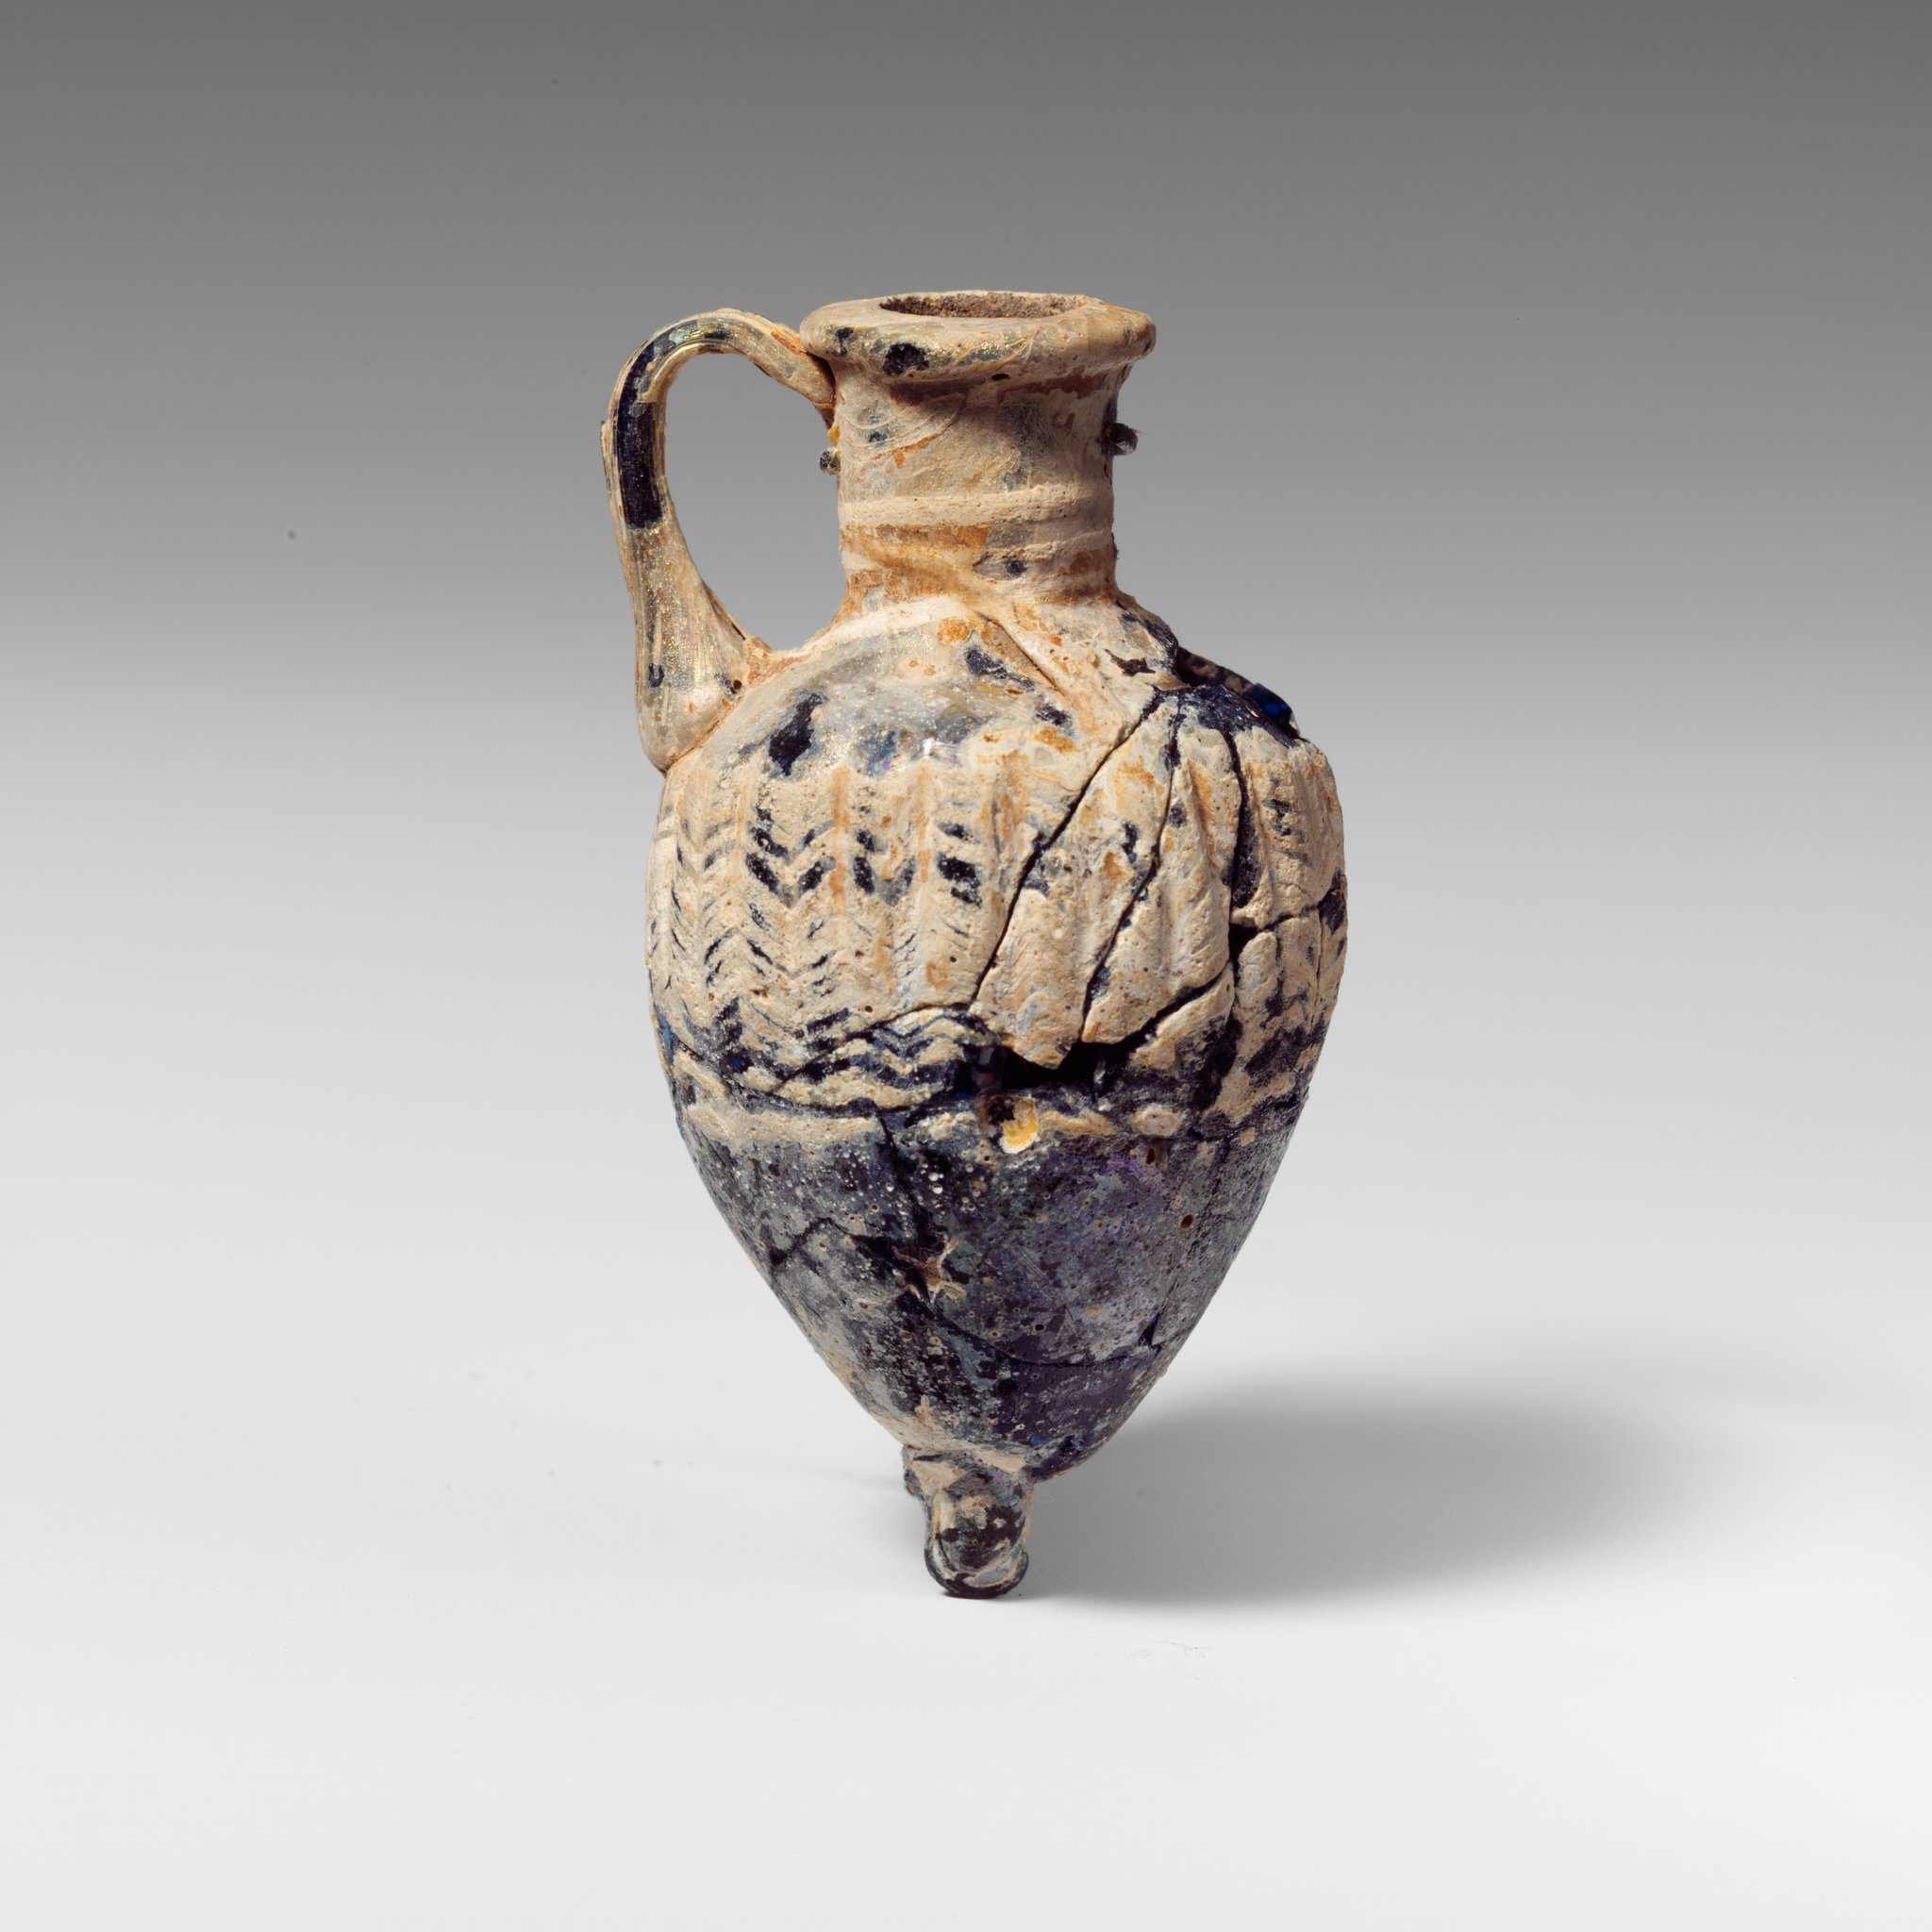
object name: amphoriskos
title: Glass amphoriskos (perfume bottle)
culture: greek or eastern mediterranean or italian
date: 400-301 BCE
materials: glass